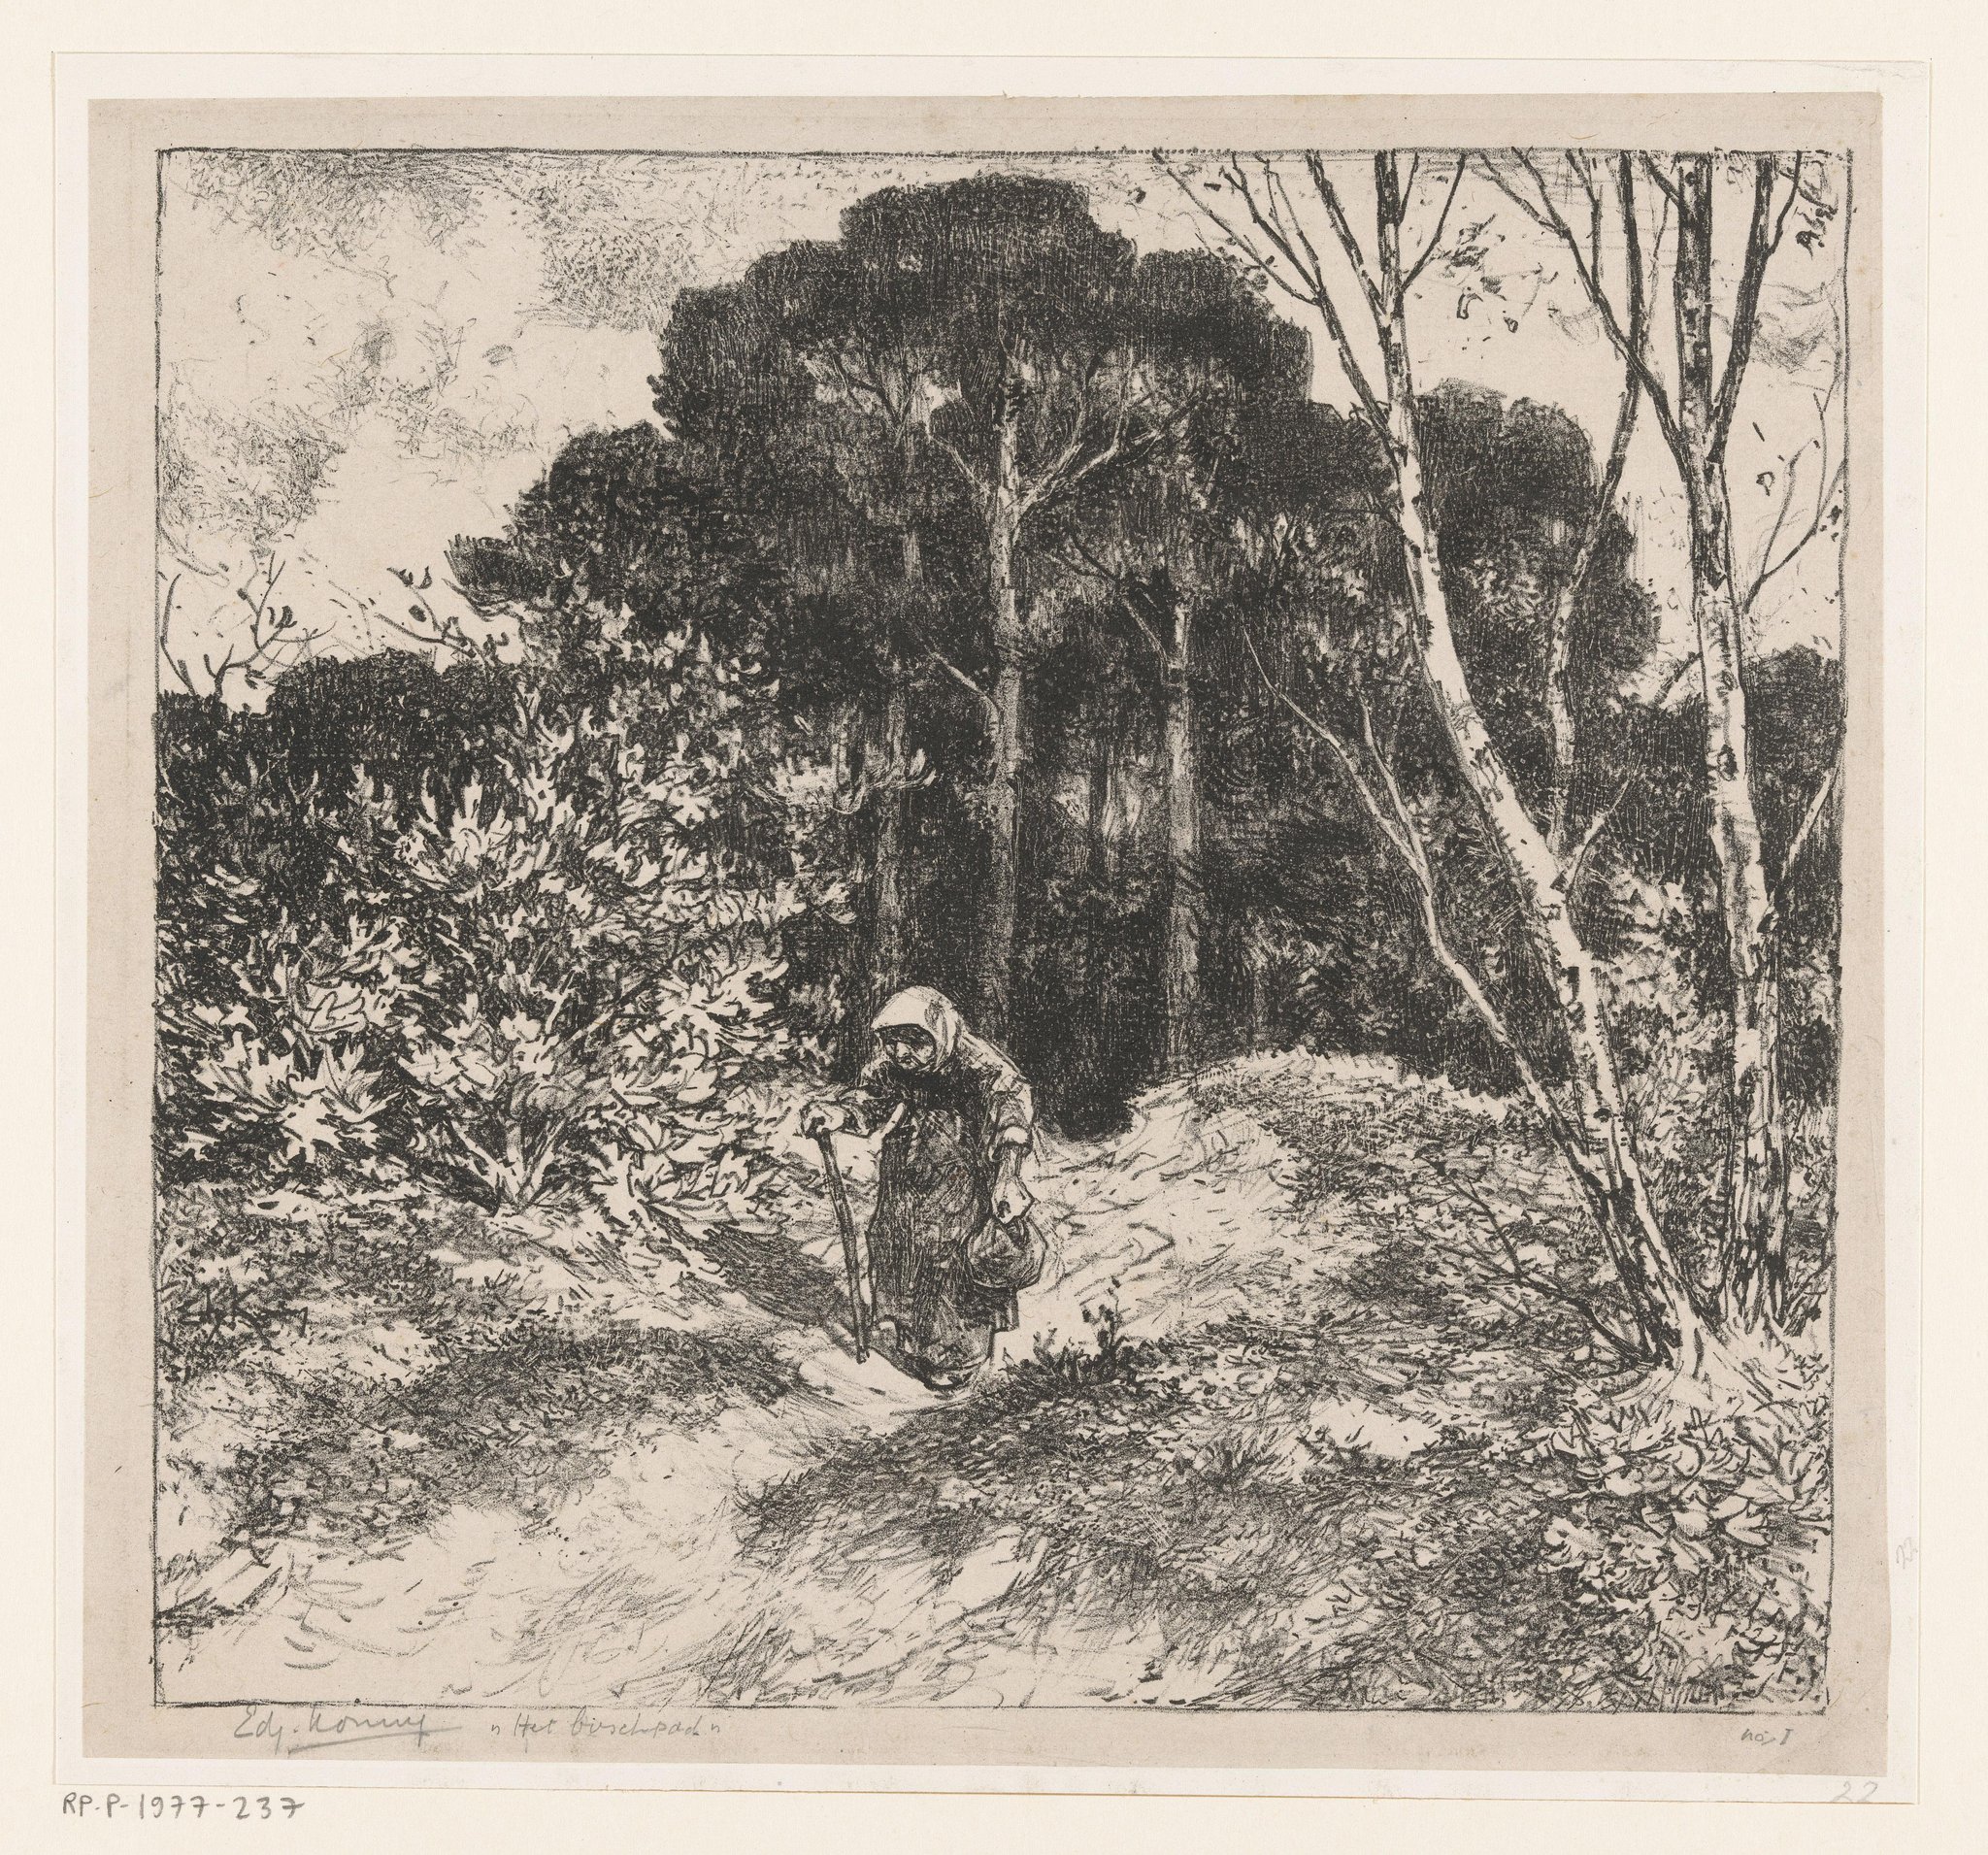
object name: print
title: Het boschpad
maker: edzard koning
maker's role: draughtsman, print maker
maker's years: 1869-1954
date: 1879-1954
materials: paper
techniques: lithograph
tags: walking-stick, staff, forest path or lane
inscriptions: collector's mark: Lugt 2760, number: ‘1’, collector's mark: Lugt 2228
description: Een vrouw wandelt met een stok over een pad in een bos.